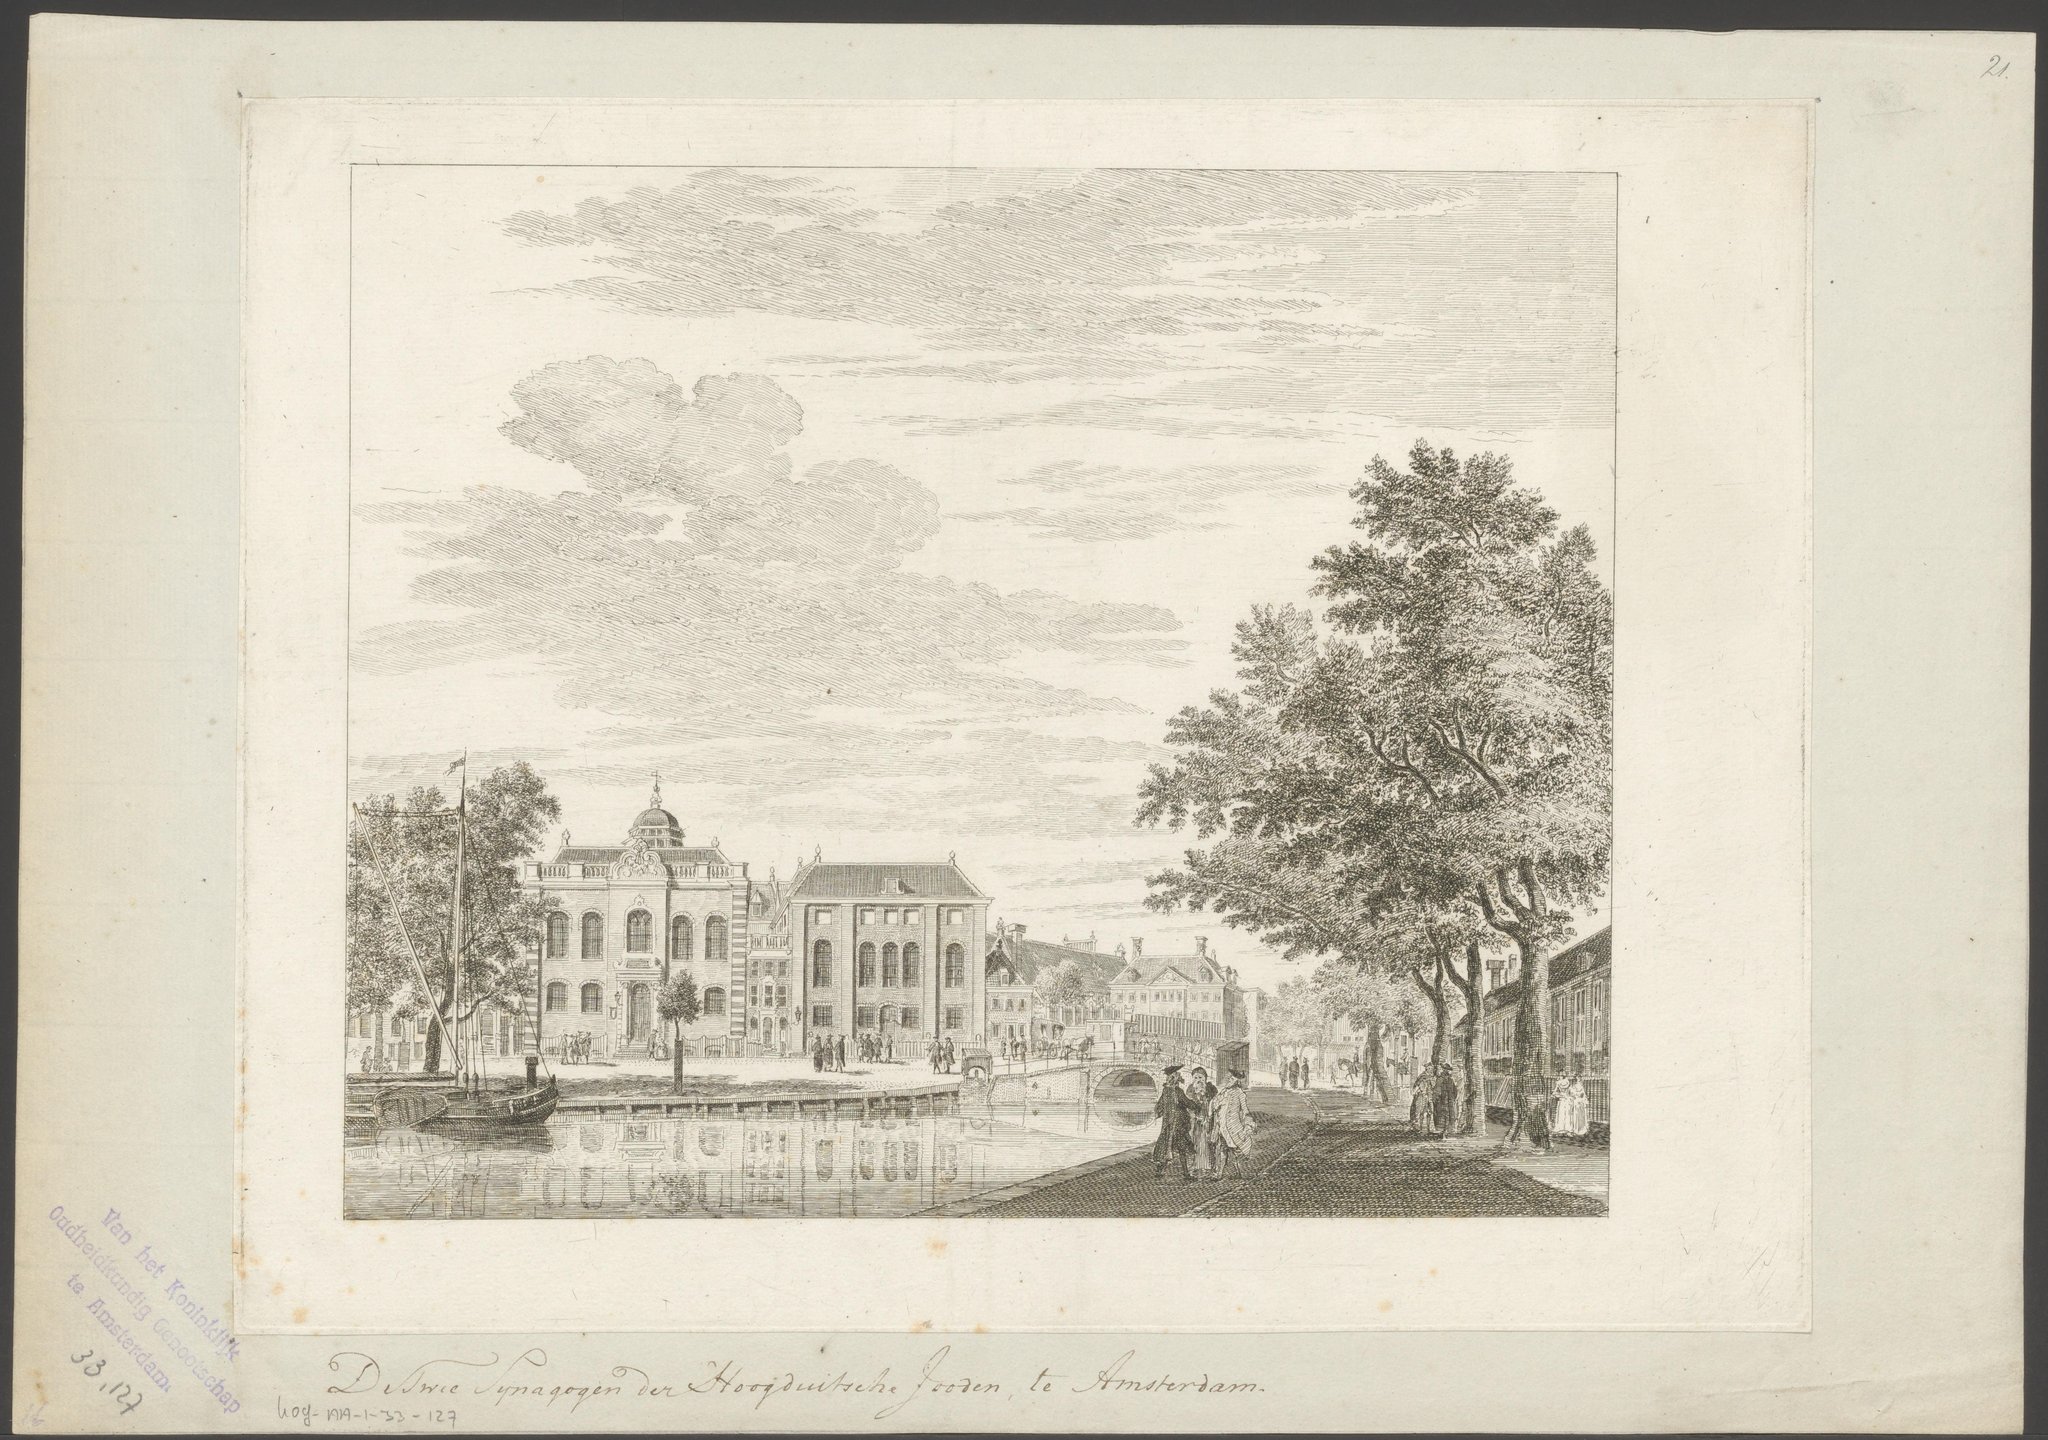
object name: print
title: Gezicht op de Nieuwe en Grote Synagoge te Amsterdam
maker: Anonymous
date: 1765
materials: paper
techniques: etching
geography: northern netherlands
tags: the synagogue (as building and place of worship ~ jewish religion), canals, waters (in city) (+ city(-scape) with figures, staffage)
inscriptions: collector's mark: ‘ Van het Koninklijk Oudheidkundig Genootschap te Amsterdam. ’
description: Latere staat (met tekst) ook gebruikt in: Wagenaar, Jan. Amsterdam, in zyne opkomst, aanwas, geschiedenissen (…). Amsterdam: Isaak Tirion, 1765, dl. 2. En in: Verzameling der fraaiste gezigten van Amsterdam in negen en zeventig afbeeldingen. Amsterdam en Harlingen: Petrus Conradi en Volkert van der Plaats, 1782.